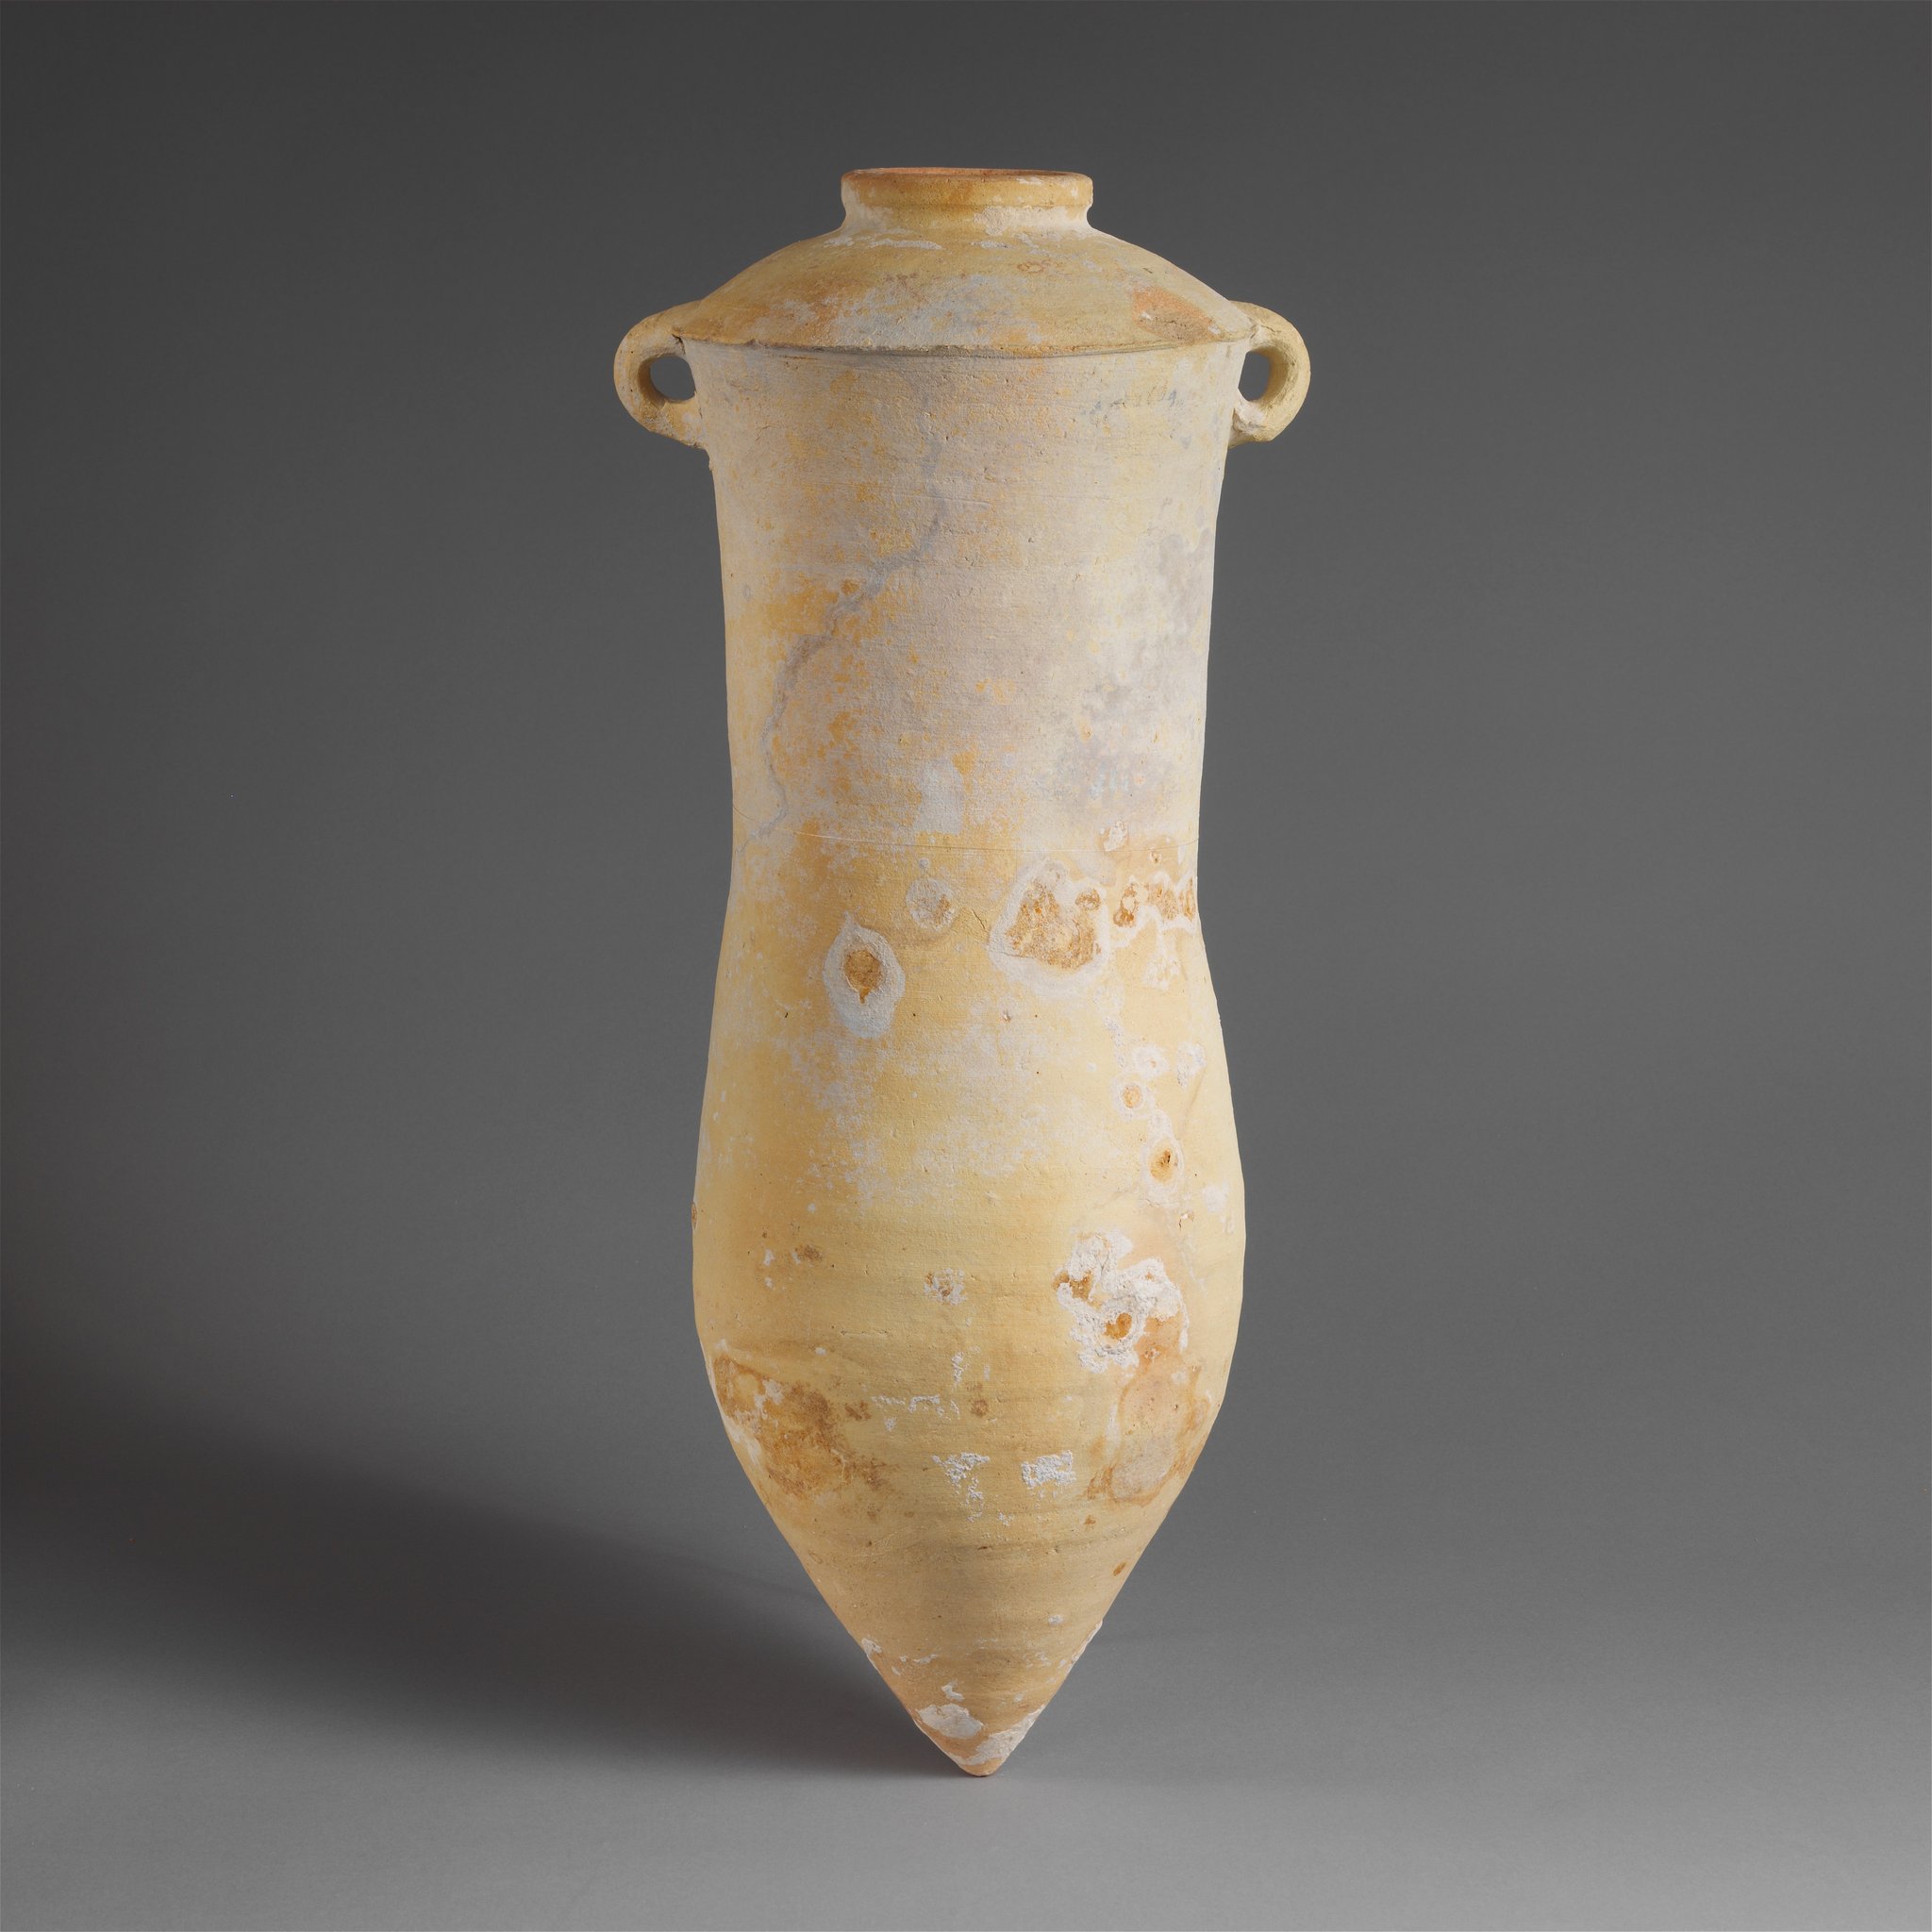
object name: amphora with phoenician inscription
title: Terracotta amphora with Phoenician inscription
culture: cypriot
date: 400-301 BCE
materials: clay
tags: phoenician